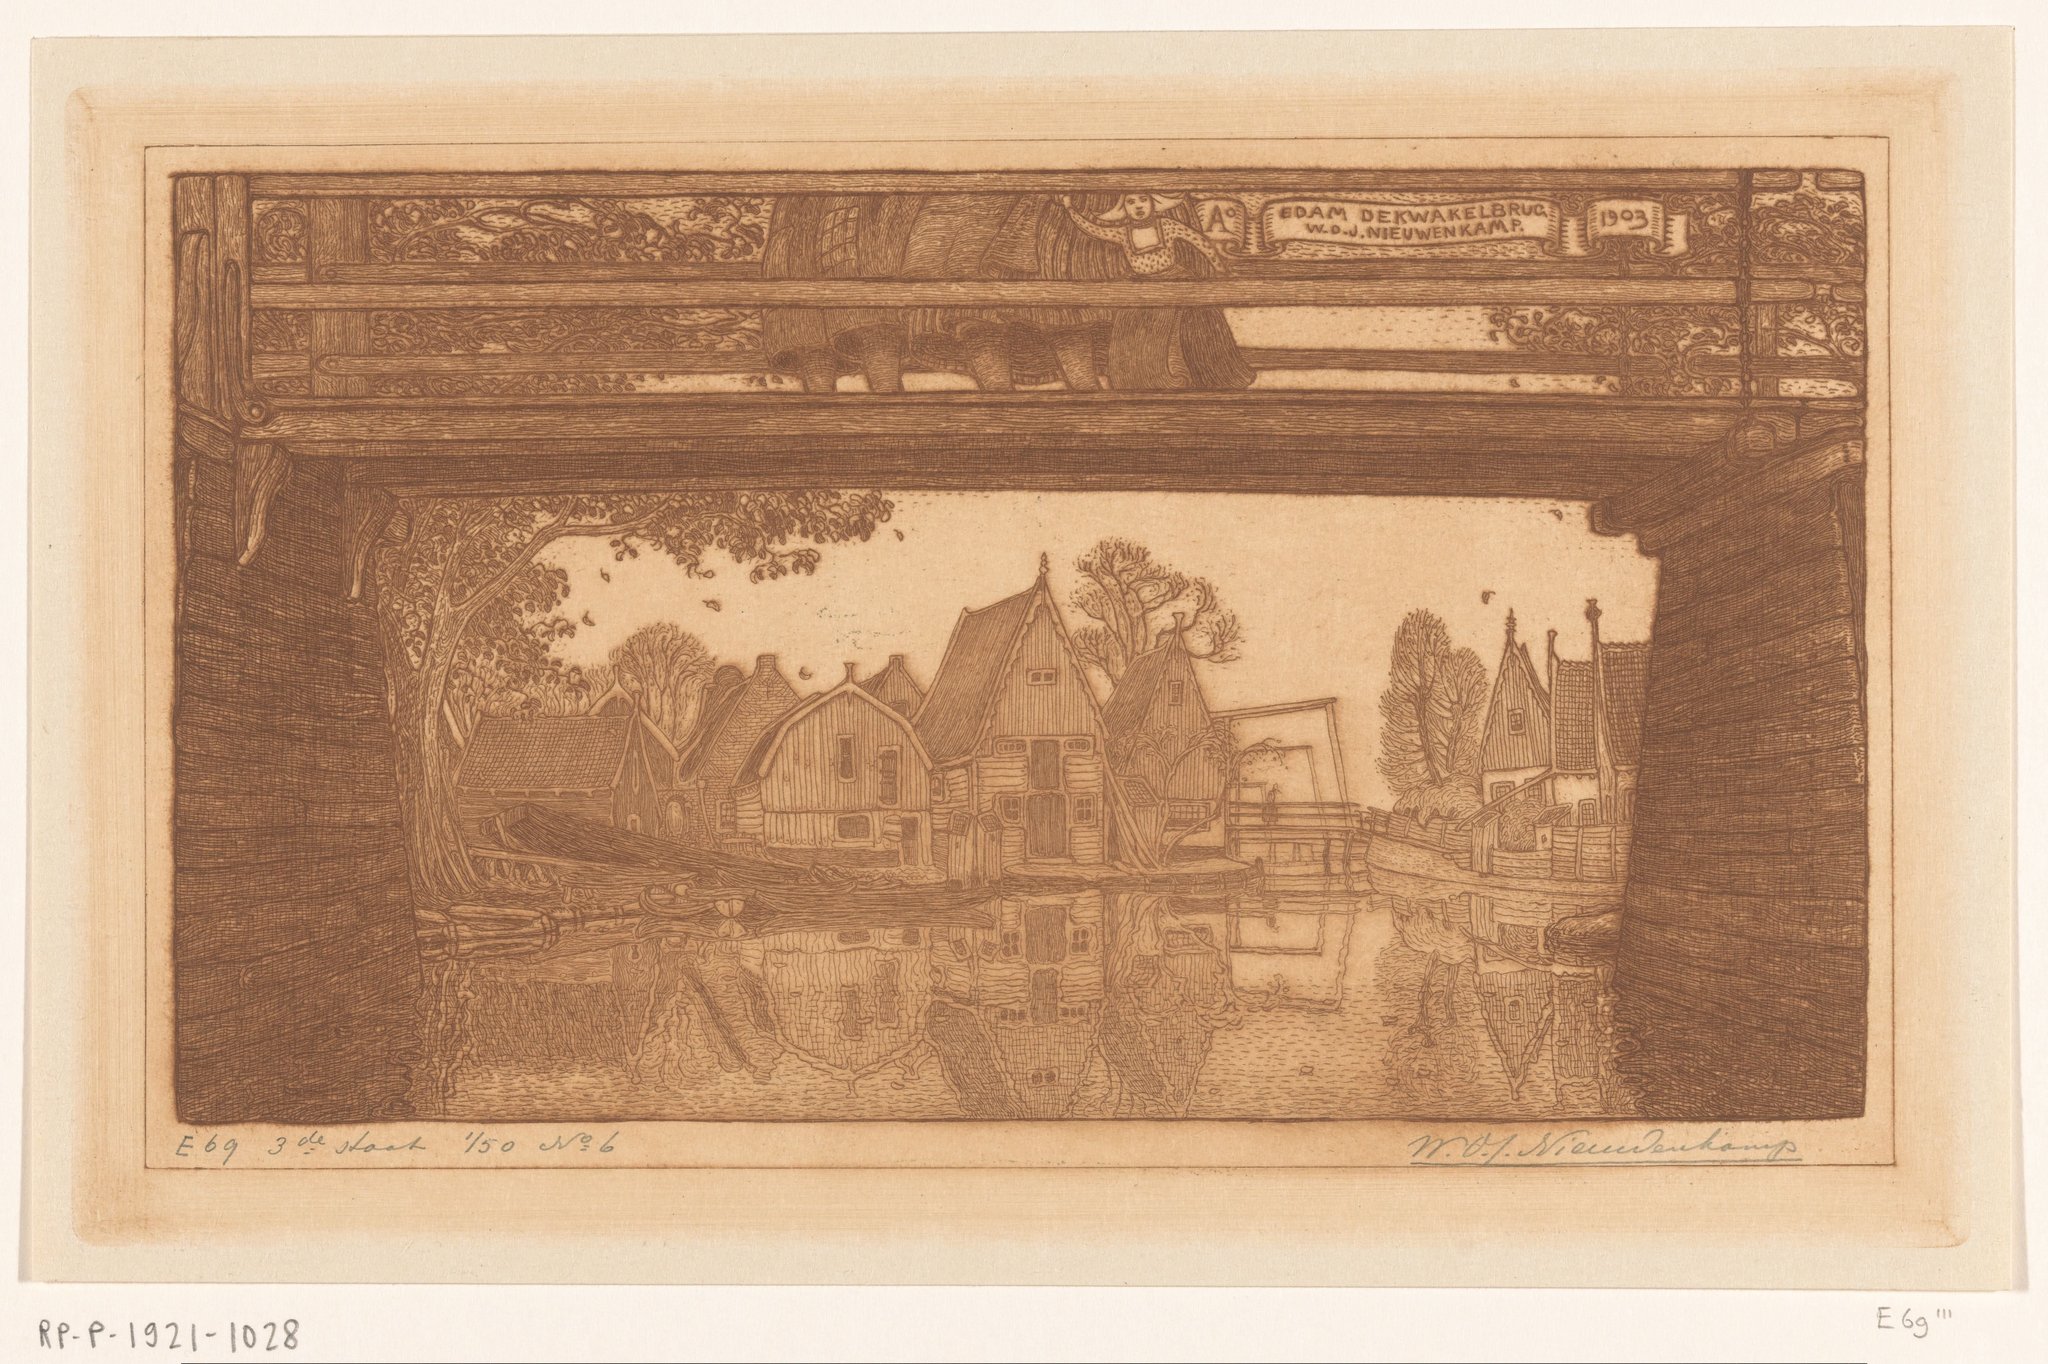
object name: print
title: Kwakelbrug in Edam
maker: wijnand otto jan nieuwenkamp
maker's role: draughtsman, print maker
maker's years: 1874-1950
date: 1903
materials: paper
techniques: etching, intaglio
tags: bascule bridge, folk costume, regional costume, bridge in city across river, canal, etc.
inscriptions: collector's mark: Lugt 2233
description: Op de brug vrouwen en een meisje in klederdracht. Op de achtergrond huizen en nog enkele ophaalbruggen.